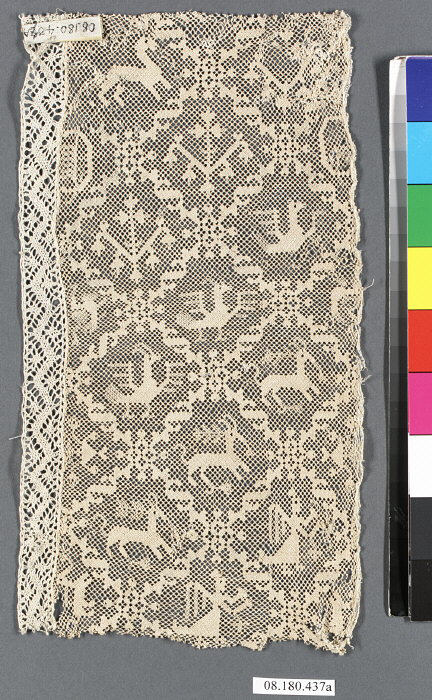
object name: fragment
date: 1501-1600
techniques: embroidery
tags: animals